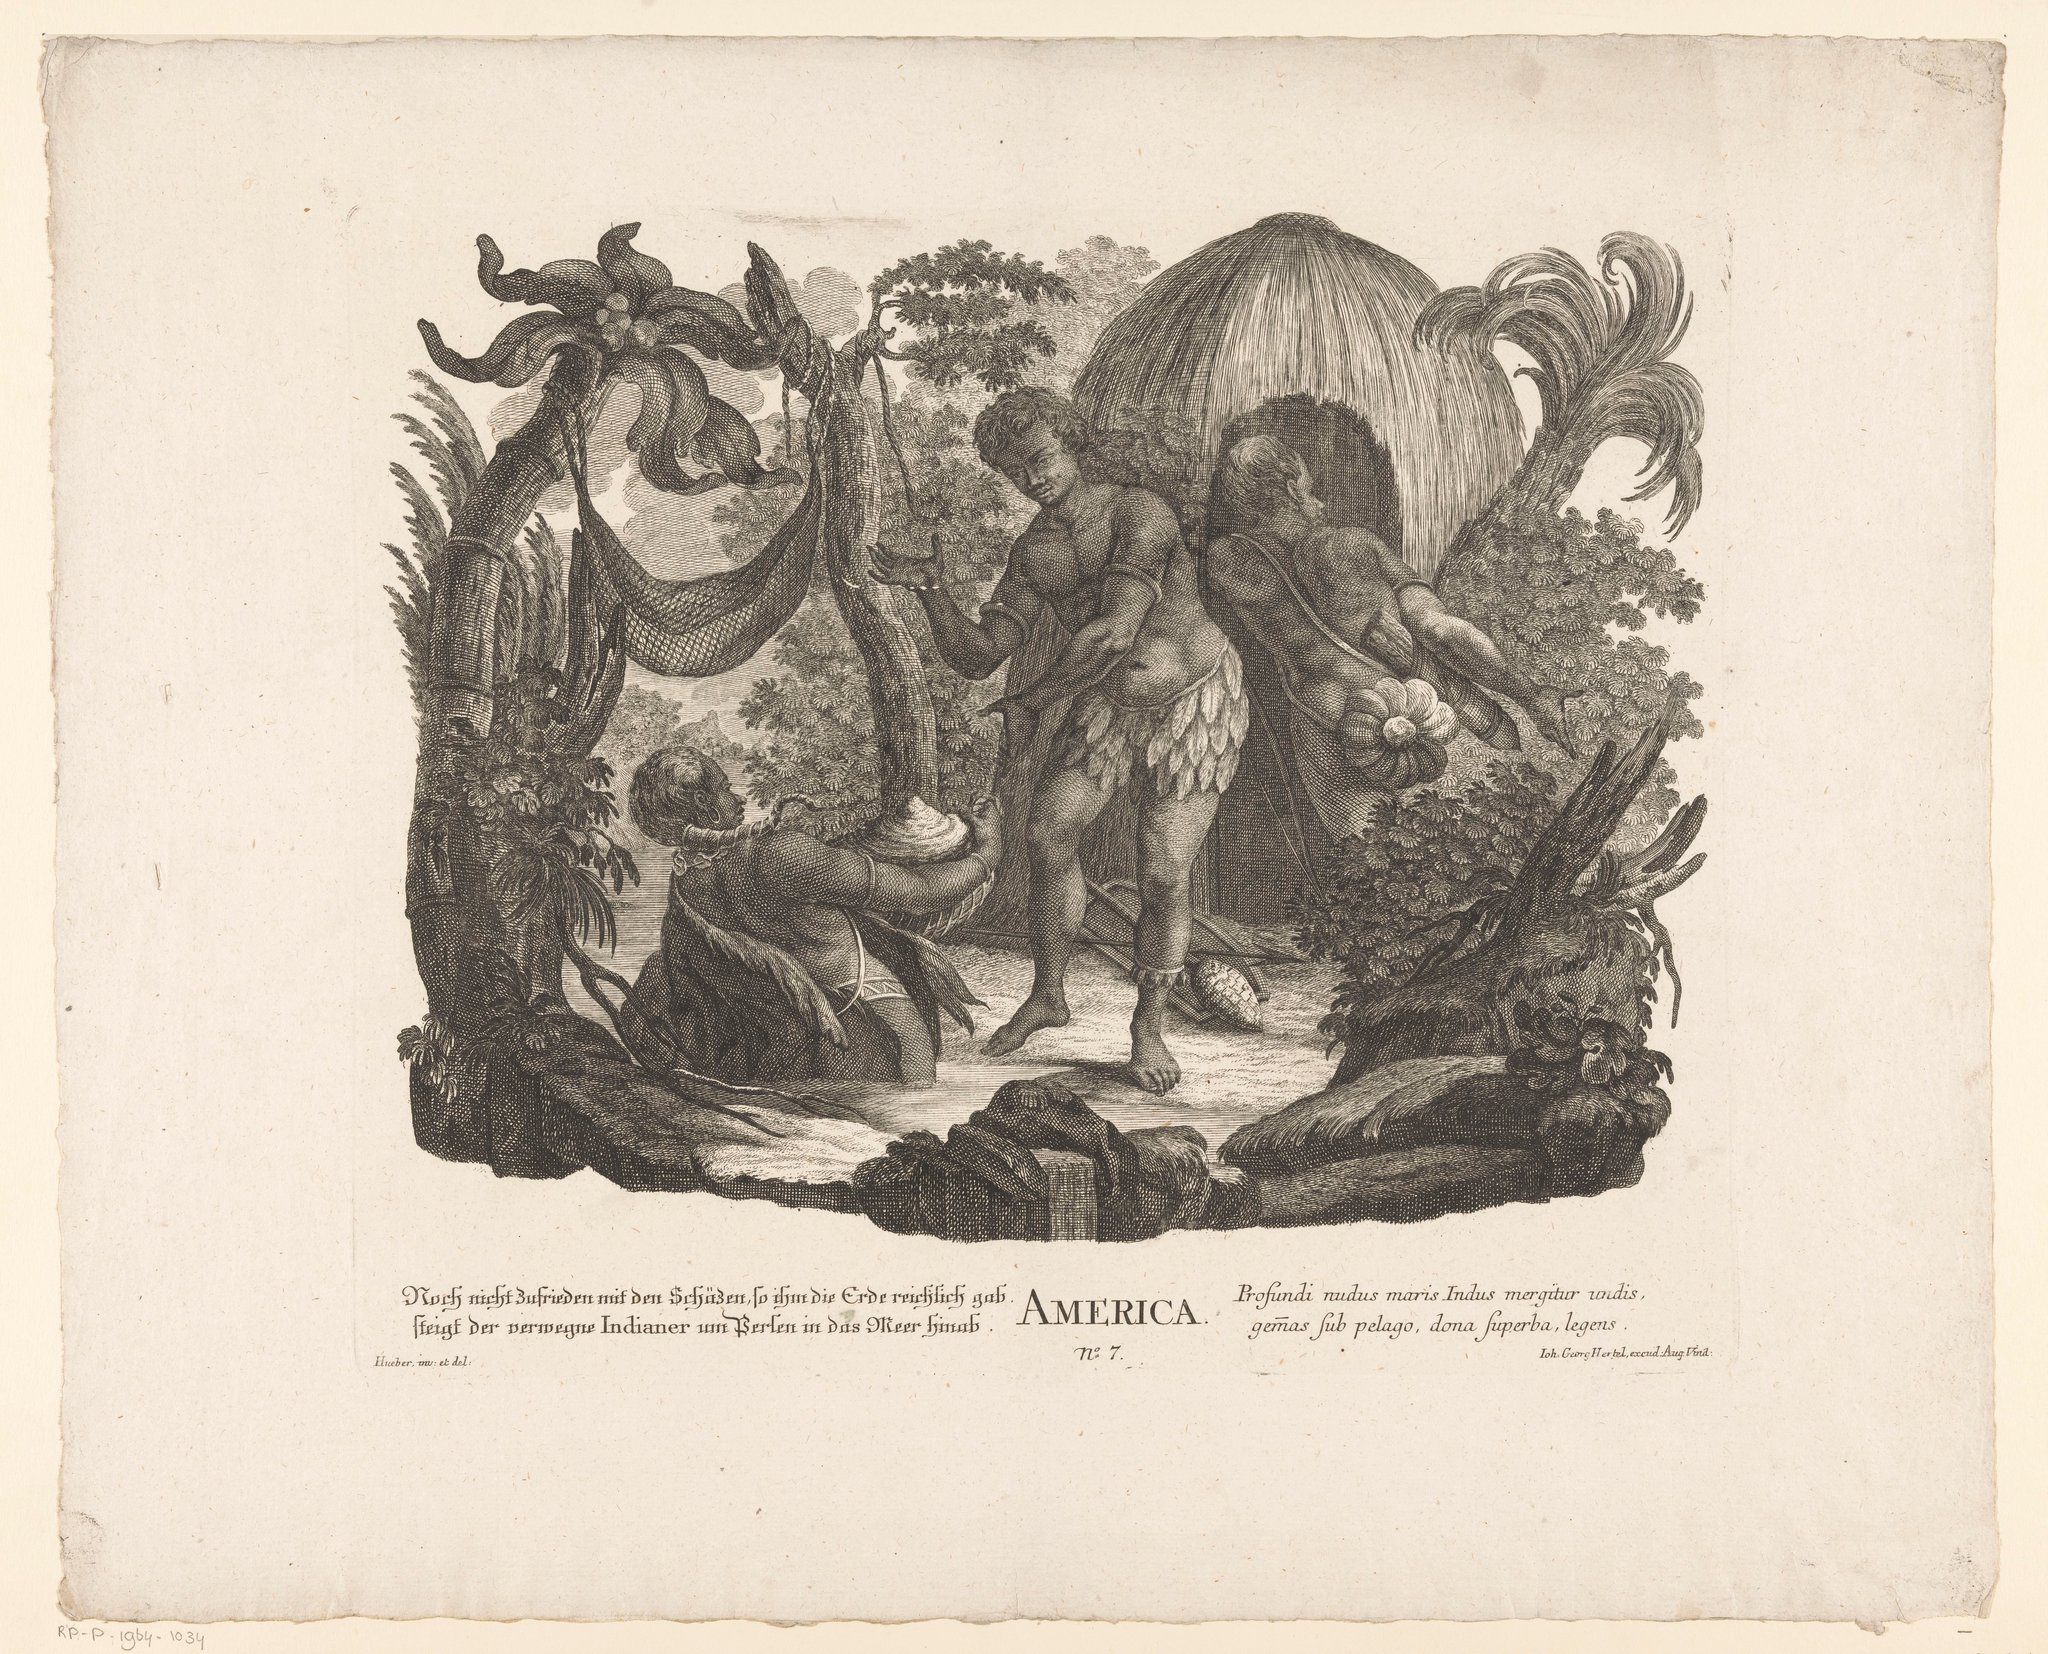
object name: print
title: America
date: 1705-1775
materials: paper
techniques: etching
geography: augsburg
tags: america represented allegorically; 'america' (ripa), native peoples of the americas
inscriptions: collector's mark: Lugt 2228, collector's mark: Lugt 2760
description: Allegorie van het werelddeel Amerika. In een landschap staat een inheemse vrouw met een mand in het water. Een inheemse man met lendendoek met veren aan de oever reikt naar de mand. Een tweede inheemse man met een pijlenkoker loopt rechts een rieten hut binnen. Links tussen twee bomen hangt een hangmat. De man in het midden draagt een mantel en een parasol. In de ondermarge een tweeregelige Duitse en Latijnse tekst. Uitgeversnummer 7.